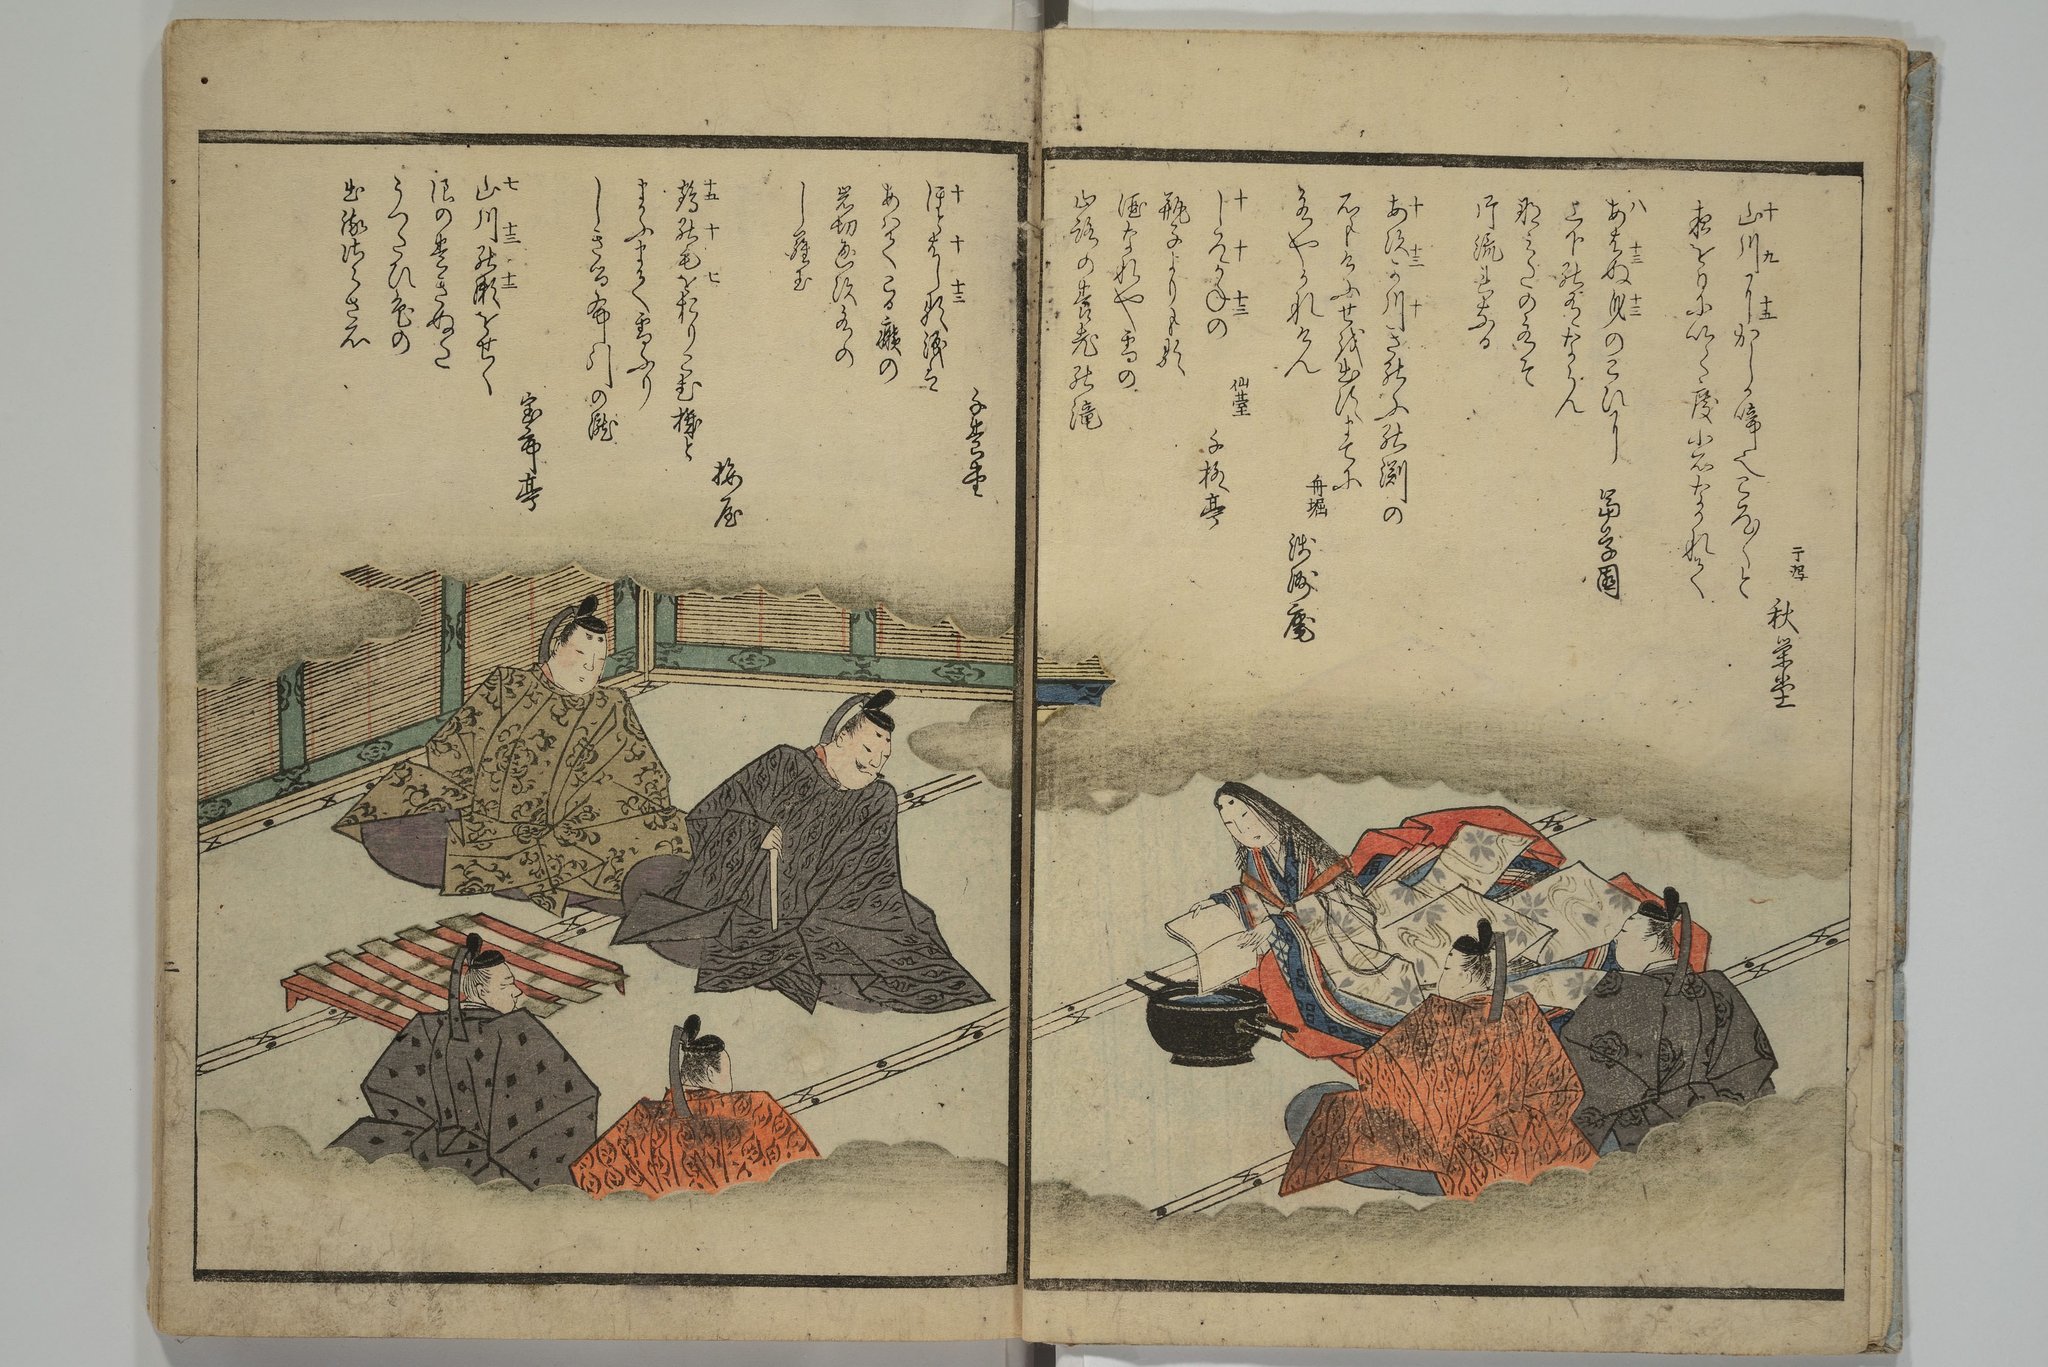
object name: illustrated book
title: The Surface of the Water (Mizu no omo shū) 水之面集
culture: japanese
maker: komatsubara suikei 小松原翠渓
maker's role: artist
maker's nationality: japanese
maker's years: 1780-1833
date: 1831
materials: ink, paper, pigment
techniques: woodblock print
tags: men,women,rain,umbrellas